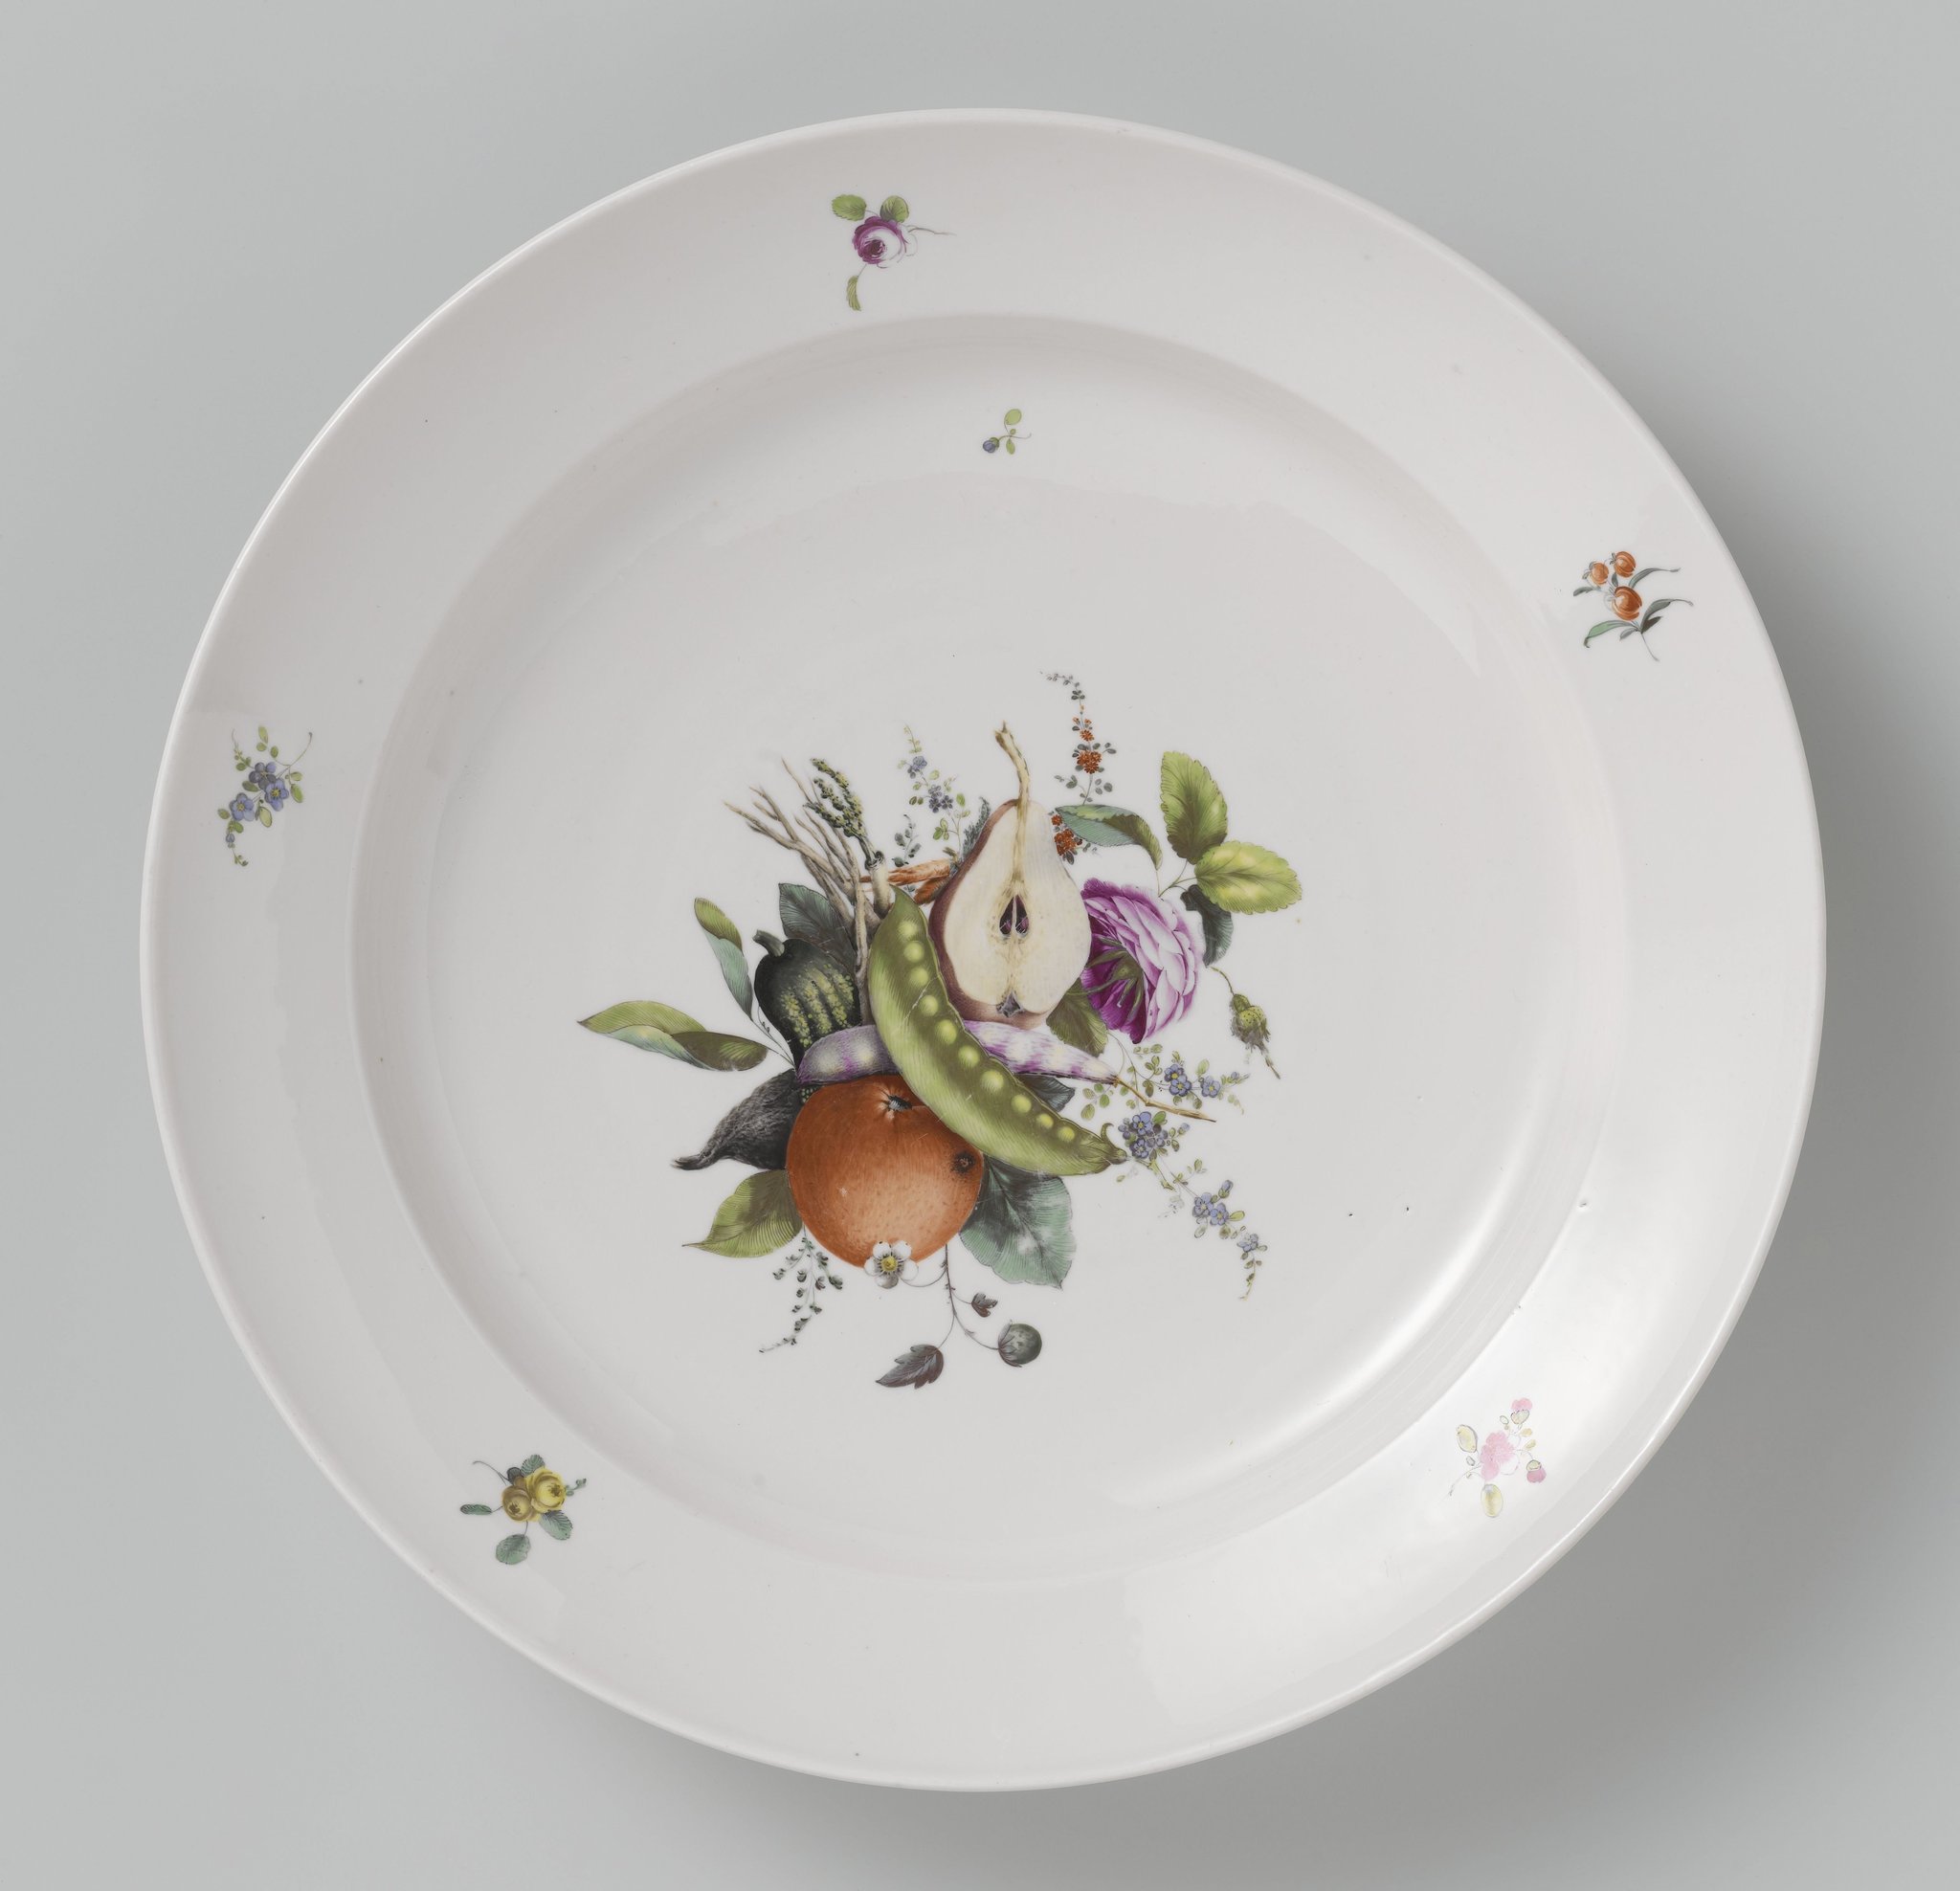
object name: platter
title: Onderschotel voor punchkom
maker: Anonymous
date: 1777-1790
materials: porcelain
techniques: painted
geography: ansbach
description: De schotel is veelkleurig beschilderd met groenten, vruchten en bloemen.